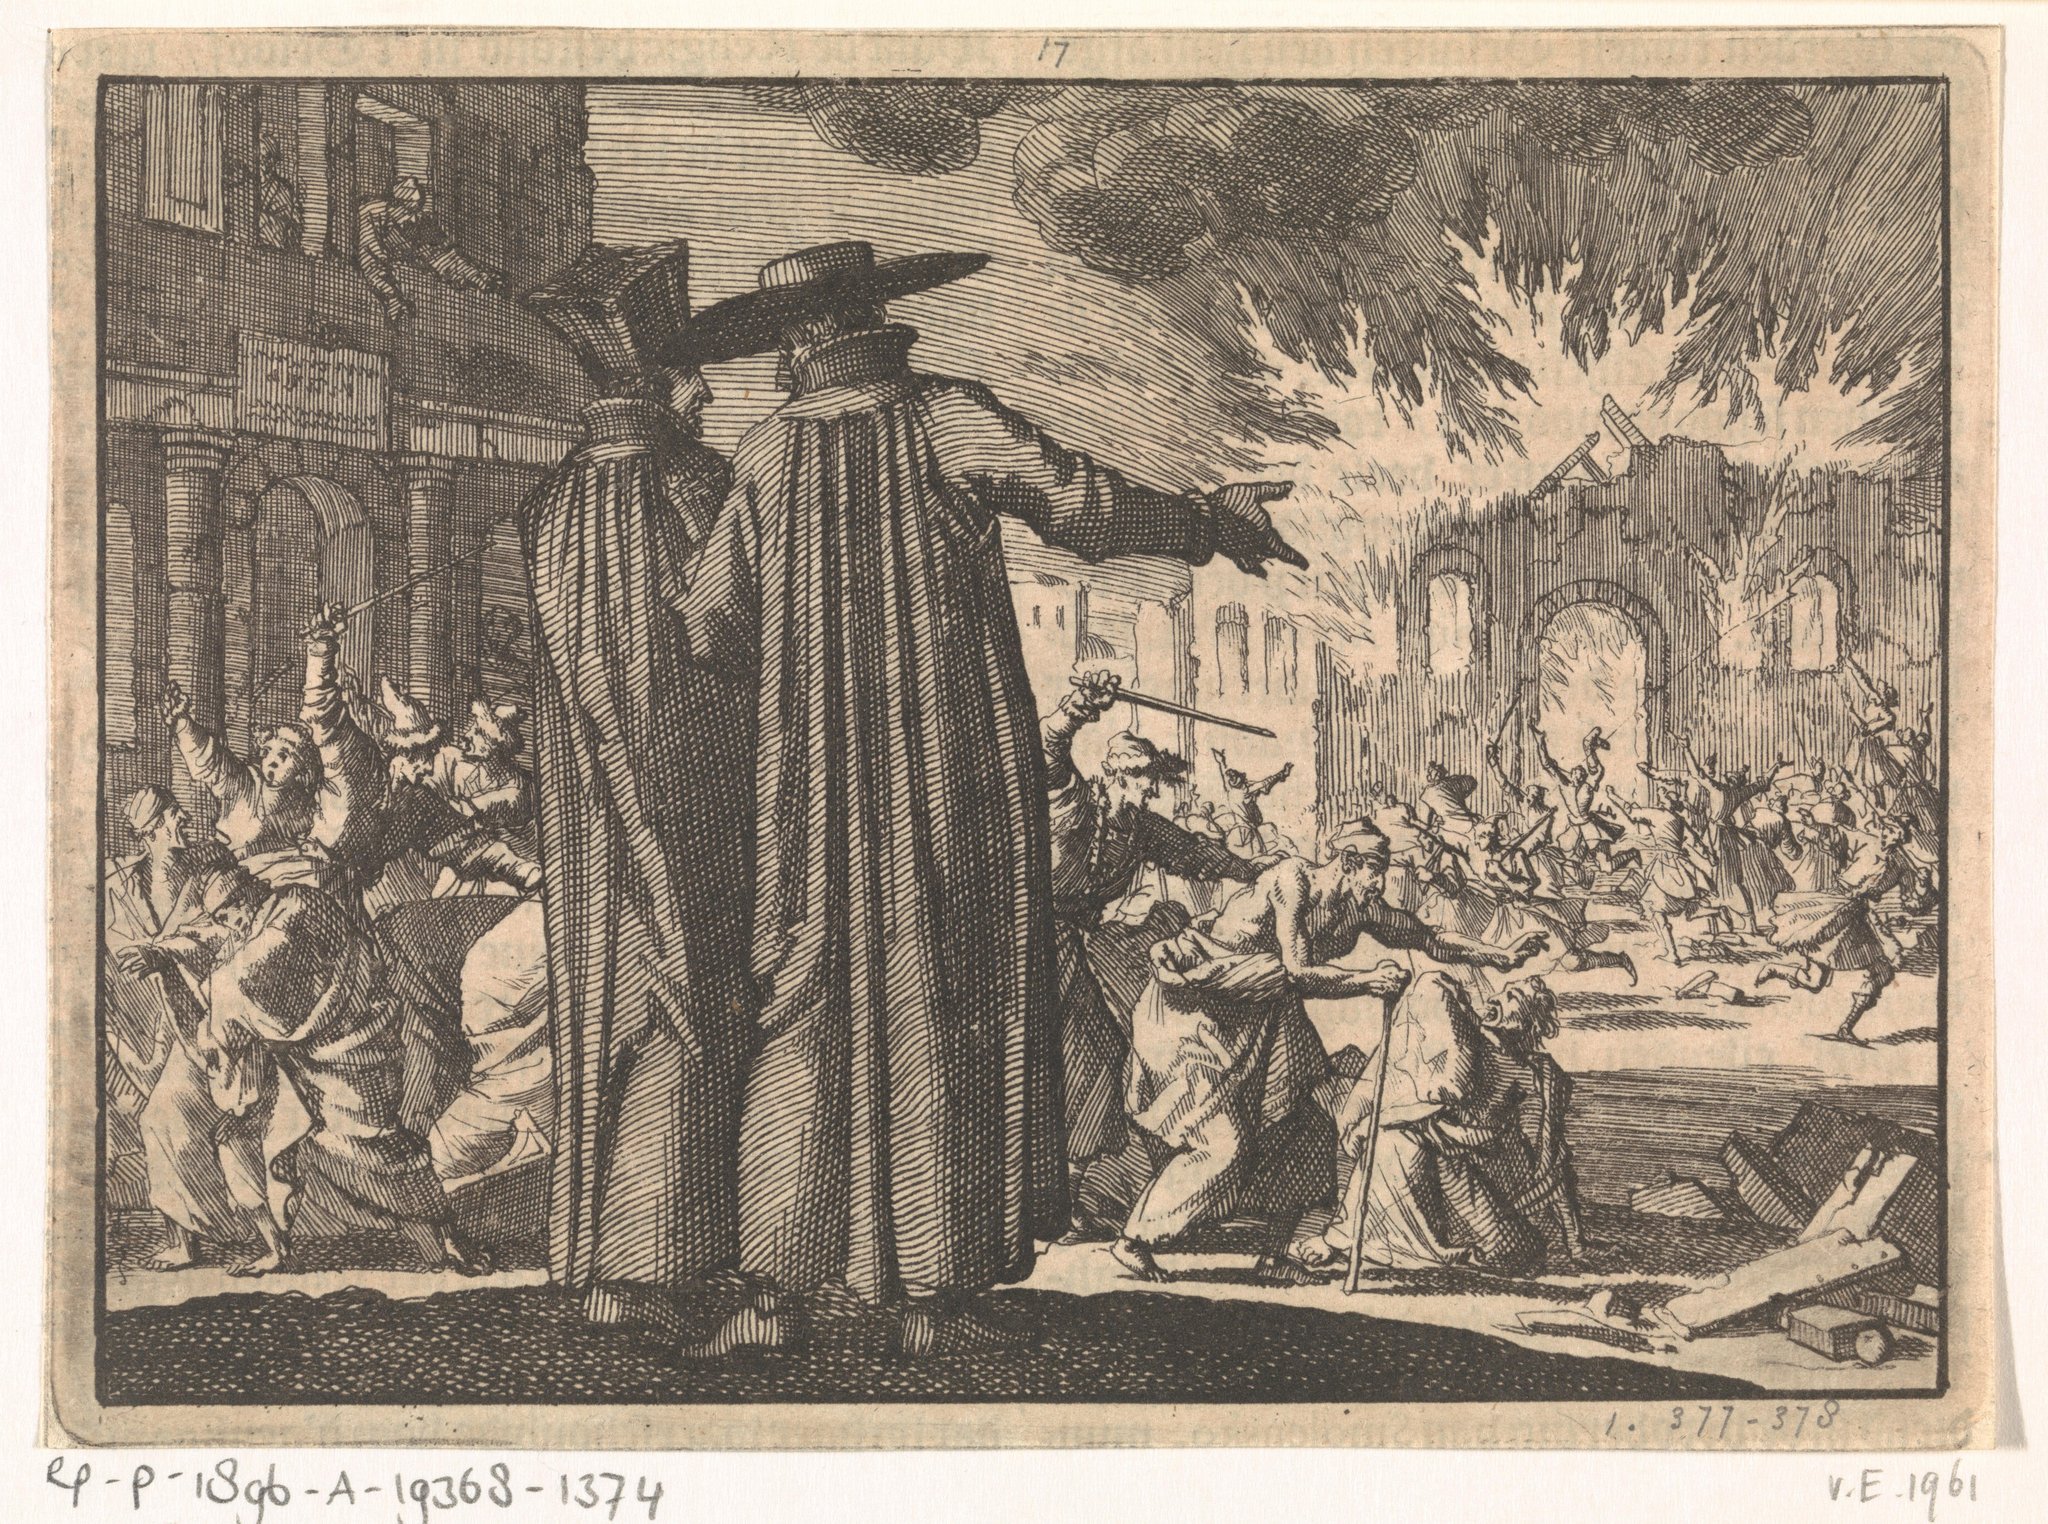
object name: book illustration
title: Vervolging van protestanten te Krakau met op de voorgrond twee Jezuïeten, 1606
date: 1698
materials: paper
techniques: etching, letterpress printing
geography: amsterdam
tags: persecution of heretics, massacre ~ war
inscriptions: collector's mark: Lugt 2228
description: Illustratie uit: Gottfried, Johann Ludwig. Historische kronyck; vervattende een (...) beschrijvingh der aldergedenckwaerdigste geschiedenissen des weerelds, van den aenvangh der scheppingh tot (...) 1576 (2 delen). Leiden: Pieter van der Aa, 1698, dl. I, p. 377.